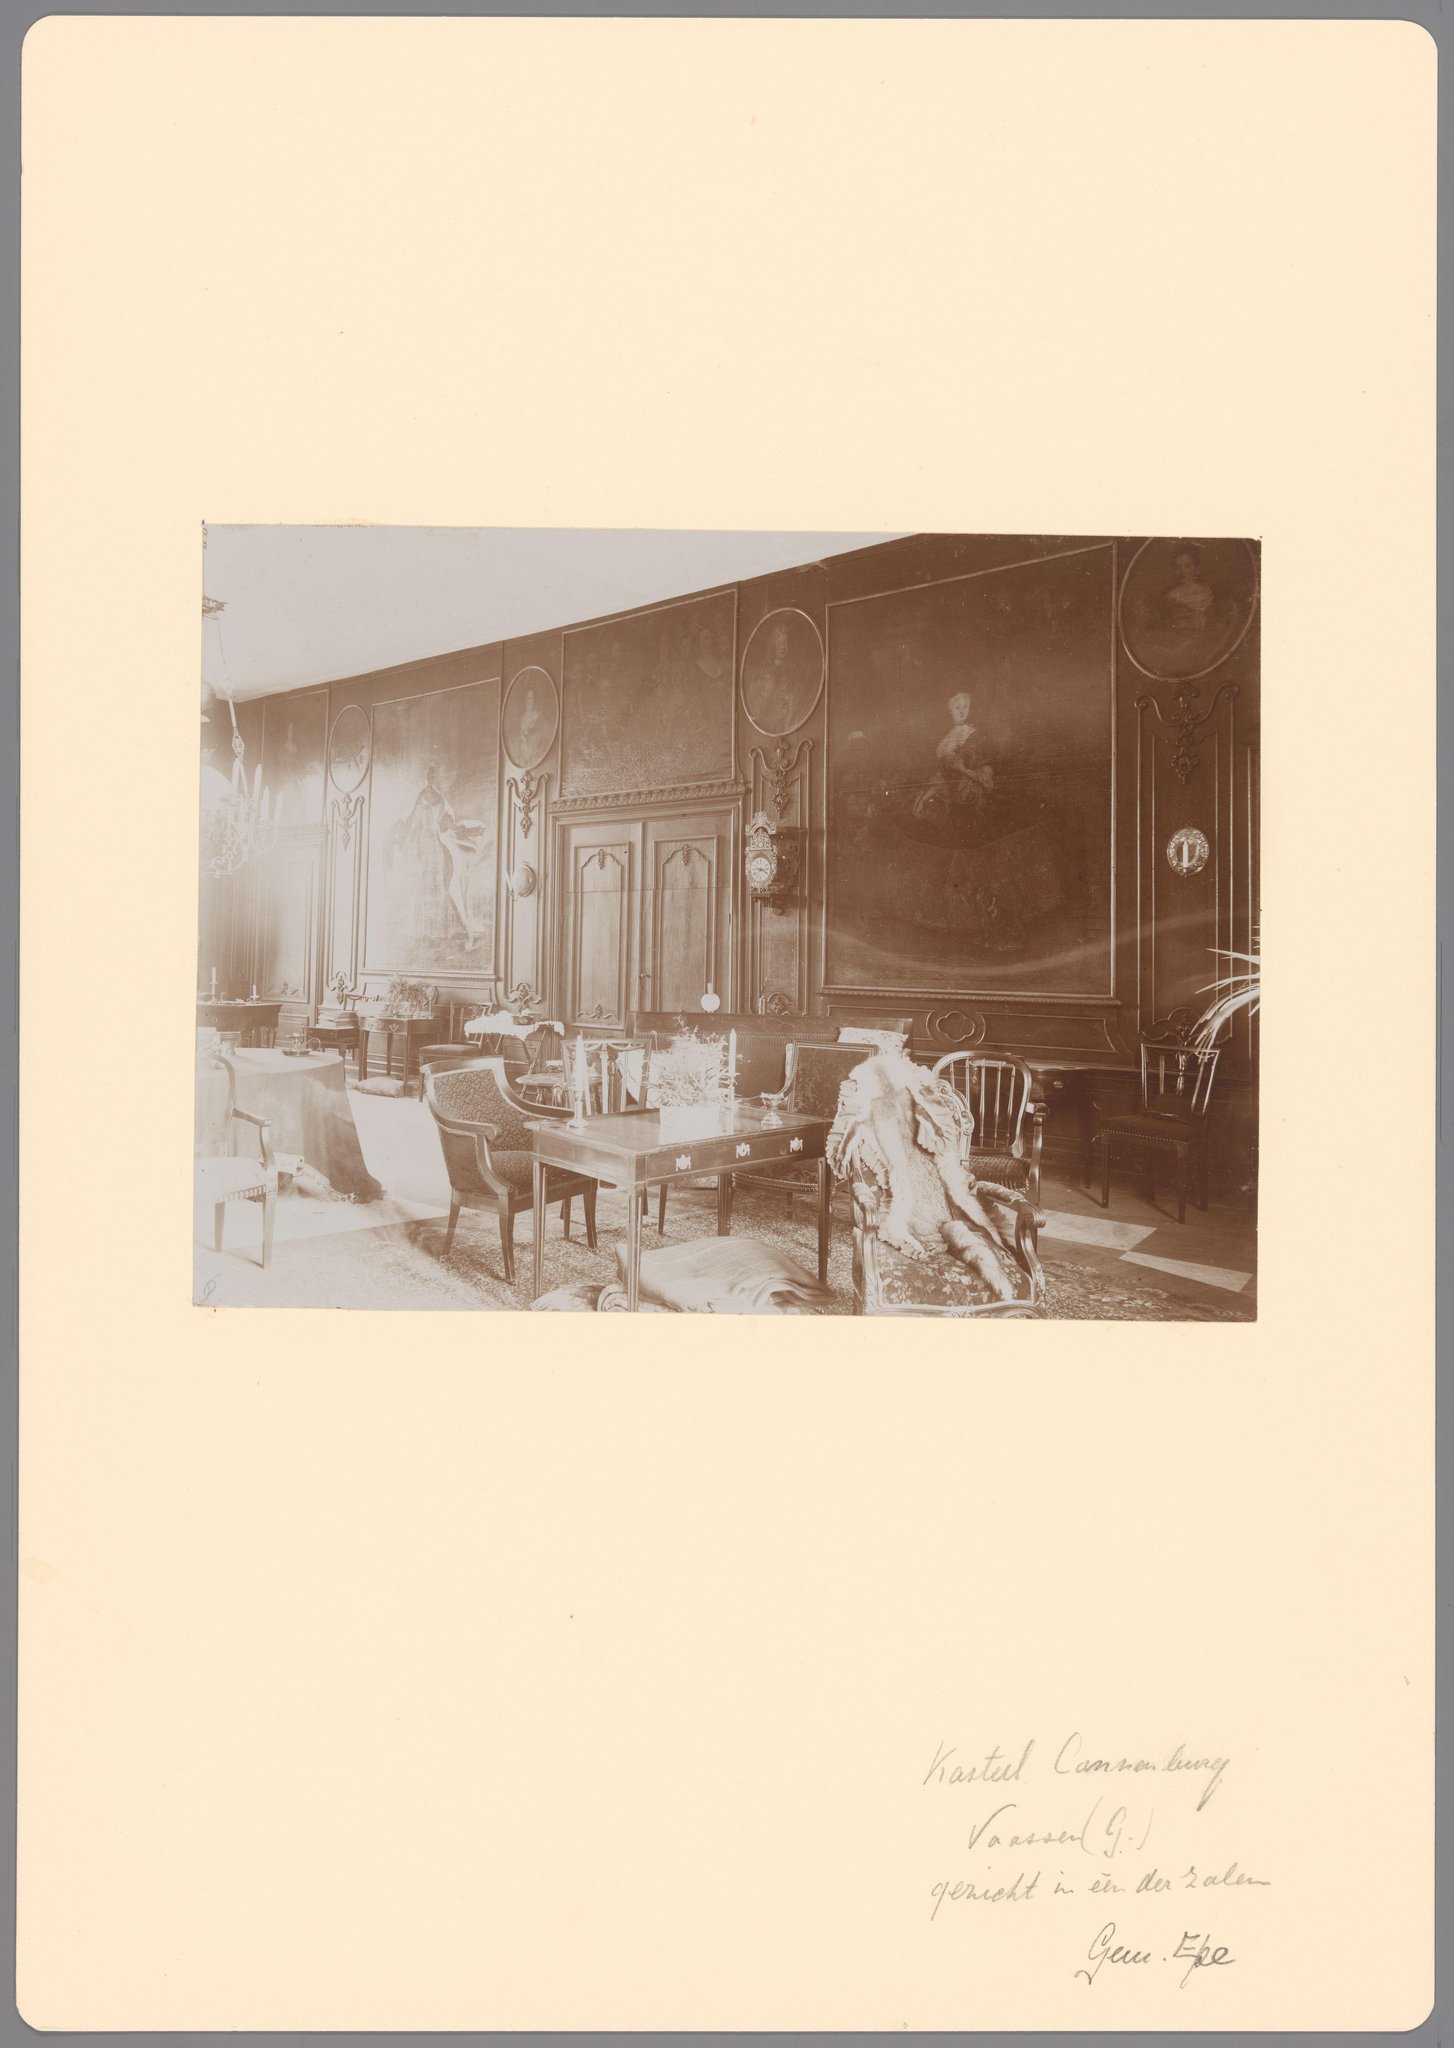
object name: photograph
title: Interieur van een zaal in Kasteel Cannenburgh te Vaassen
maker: anoniem (monumentenzorg)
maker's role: fotograaf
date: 1890-1920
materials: cardboard, photographic support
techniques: collodion silver print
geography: kasteel cannenburgh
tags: castle, living-room, parlour, sitting-room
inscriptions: annotation: ‘Q/ Kasteel Cannenburg/ Vaassen (G.)/ gezicht in één der zalen/ gem. Epe’